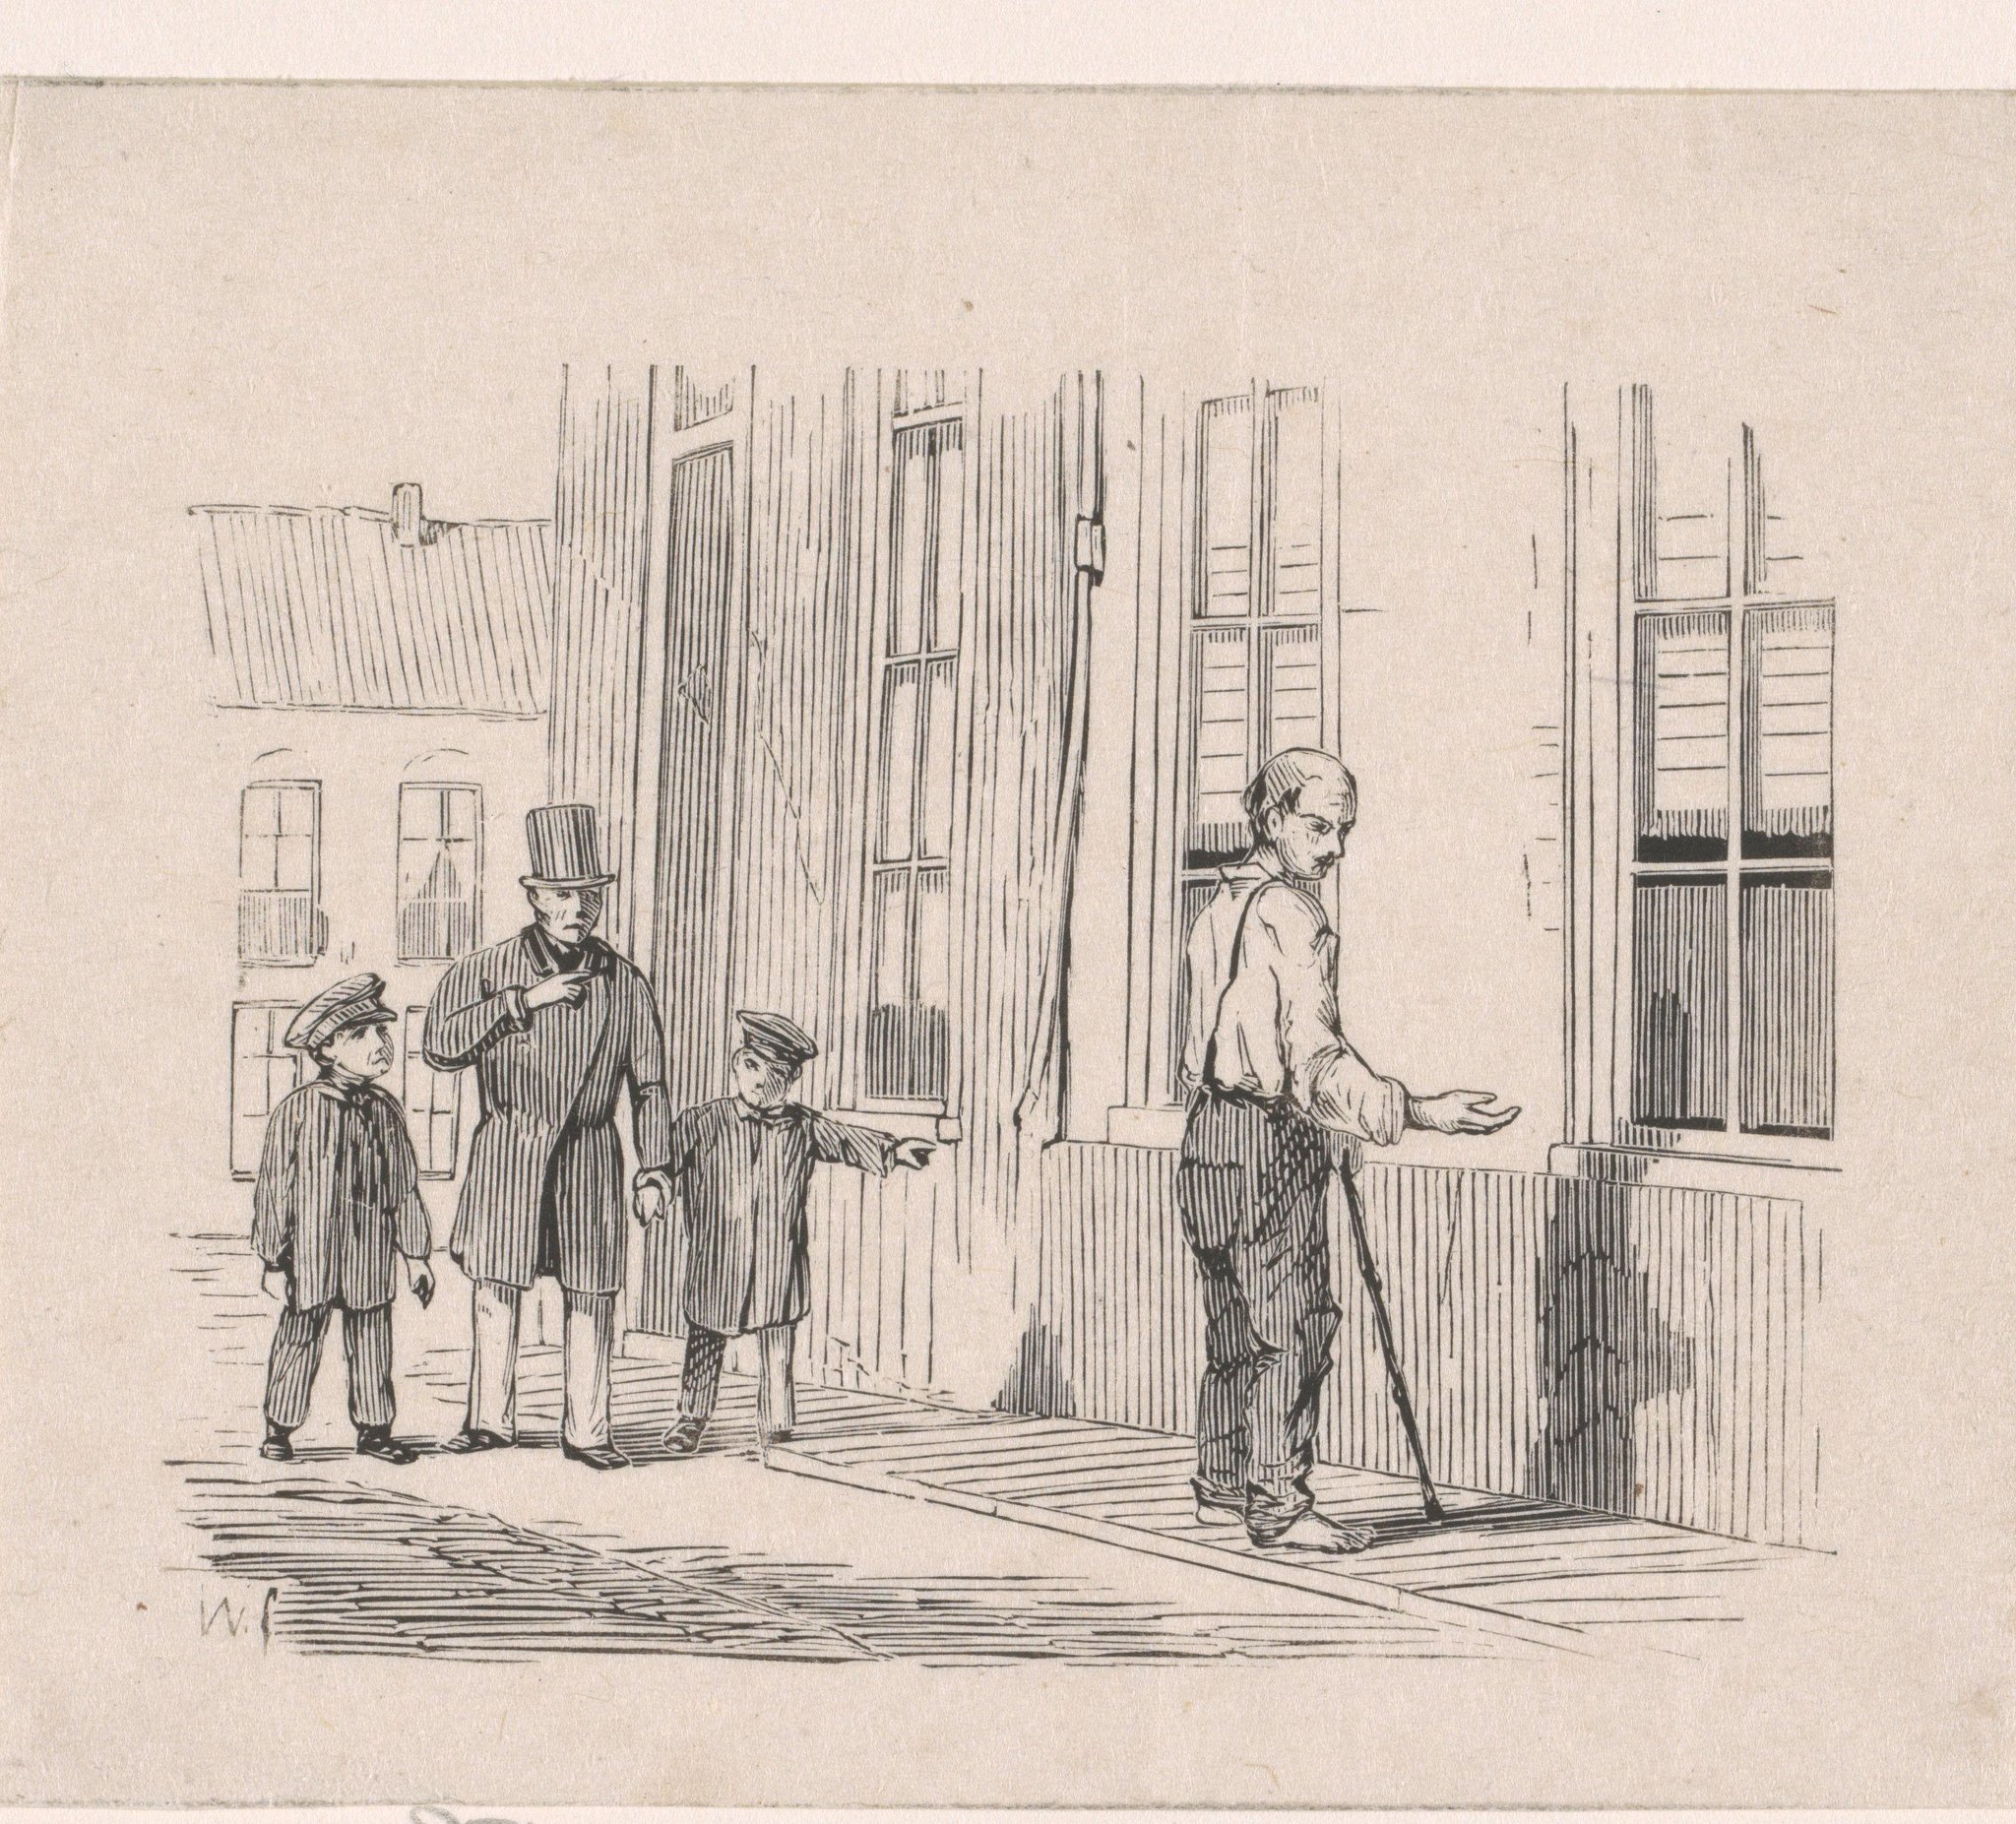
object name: print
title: Vader met twee kinderen wijzend naar een bedelaar op straat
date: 1838-1912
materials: paper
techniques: engraving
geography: netherlands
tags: alcoholic drinks, beggar, index finger forwards, pointing, indicating, father and child(ren), man and child(ren) (family group)